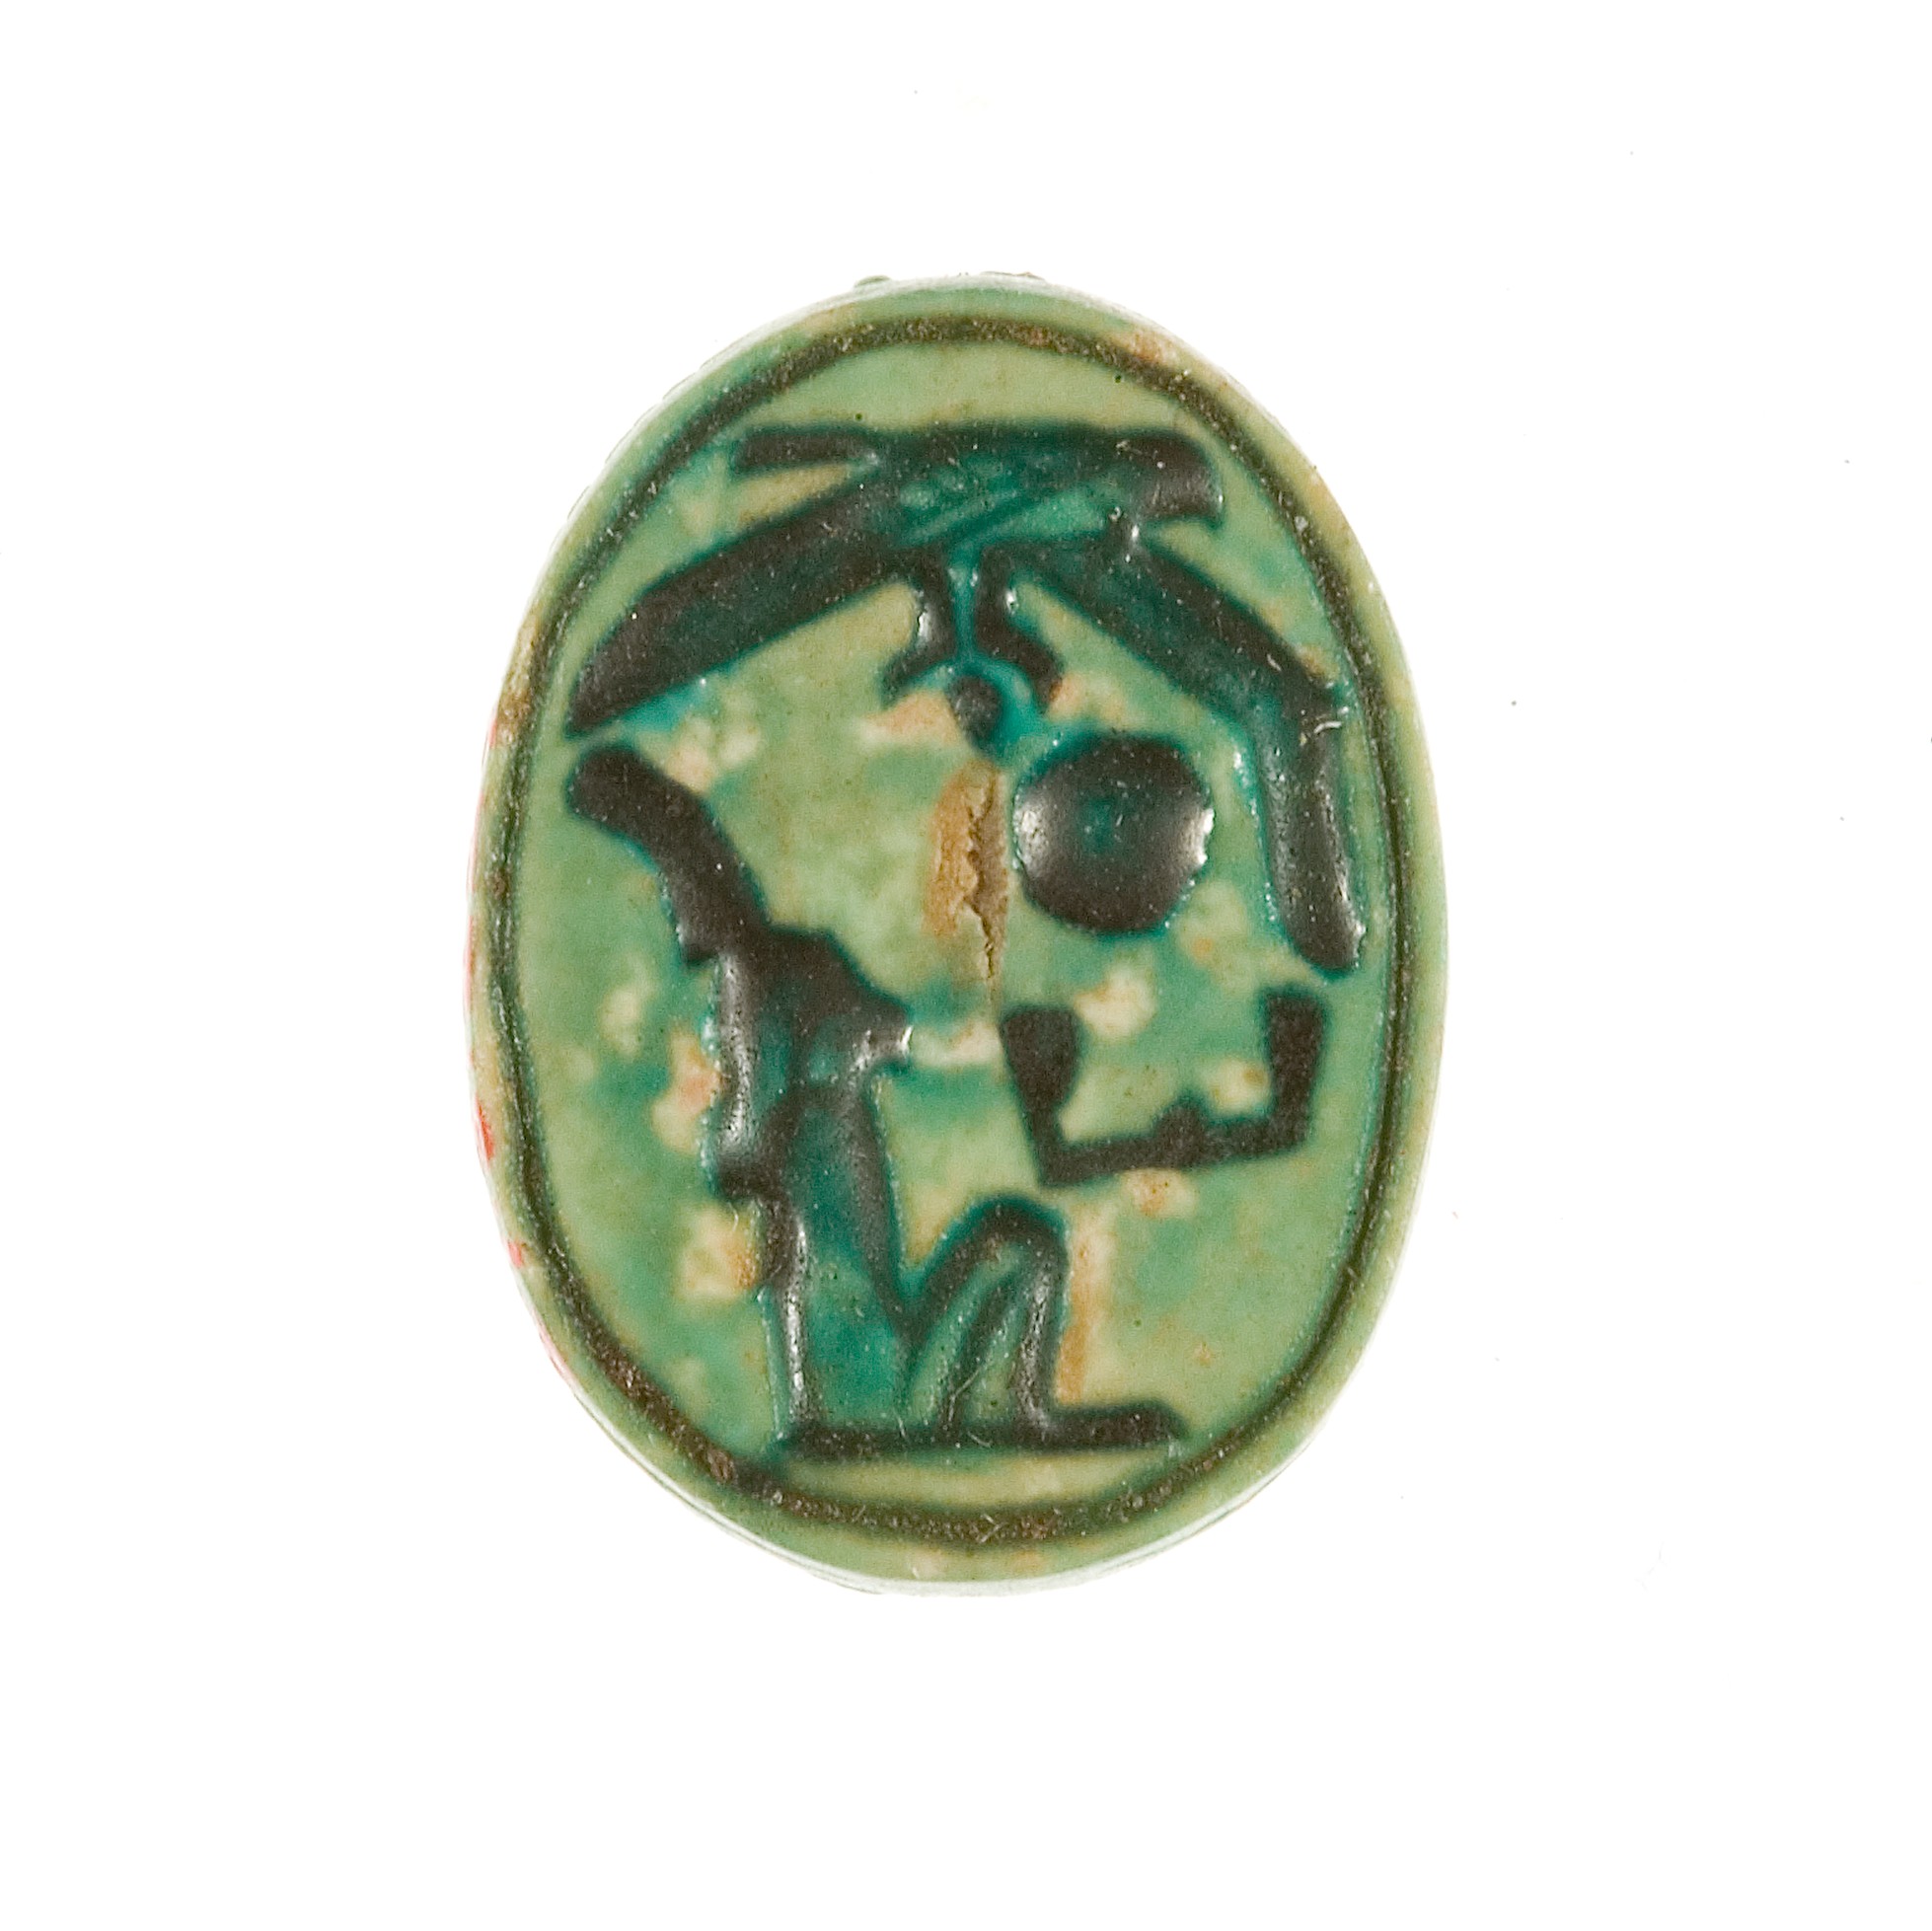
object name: scarab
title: Scarab Inscribed with the Name Maatkare (Hatshepsut) with a Falcon Above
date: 1479-1458 BCE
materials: stone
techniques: glazing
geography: egypt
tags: falcons,queens,scarabs